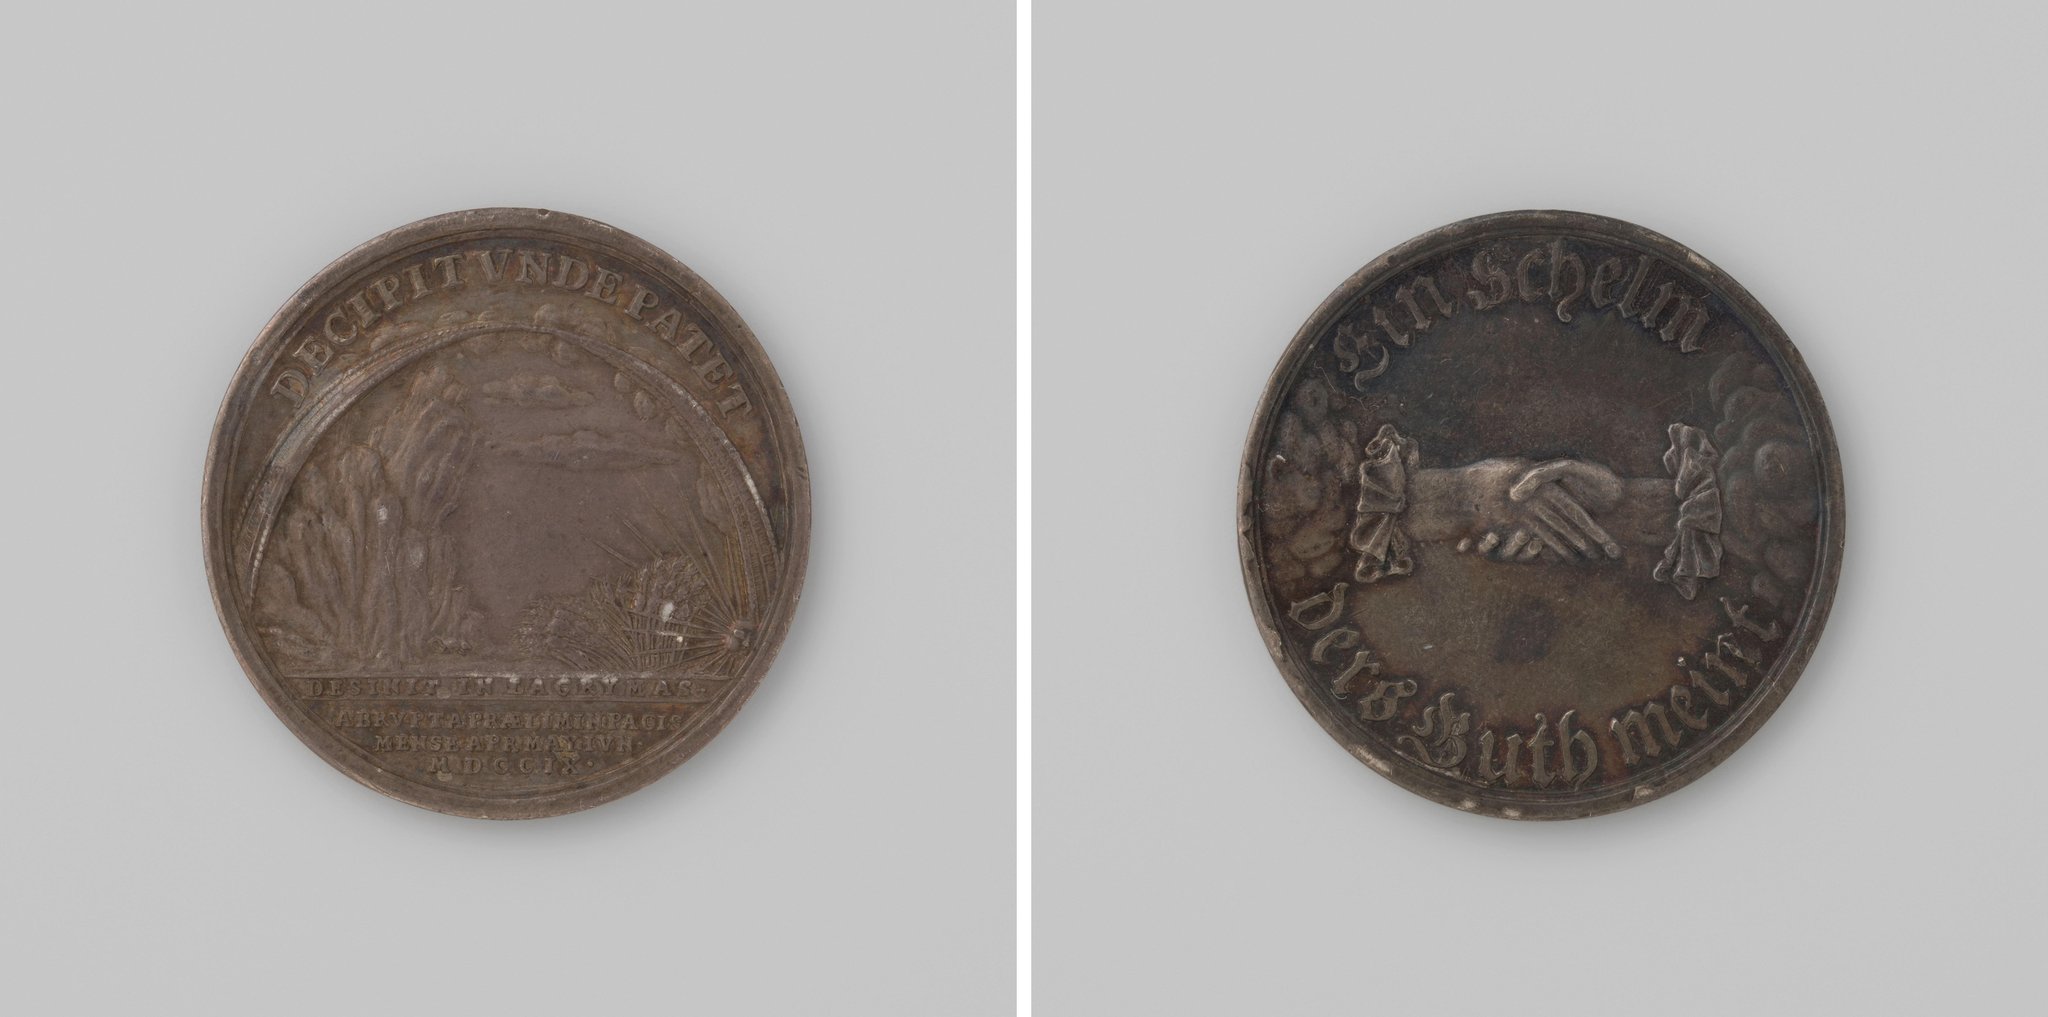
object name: history medal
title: Vredesonderhandelingen met Frankrijk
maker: christian wermuth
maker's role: medailleur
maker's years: 1661-1739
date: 1709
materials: silver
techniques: striking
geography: gotha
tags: netherlands, the hague, france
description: Zilveren penning. Voorzijde: regenboog boven rotsen en korenvelden; in verte ondergaande zon binnen omschrift, boven opschrift. Keerzijde: twee ineen geslagen handen uit wolken binnen omschrift